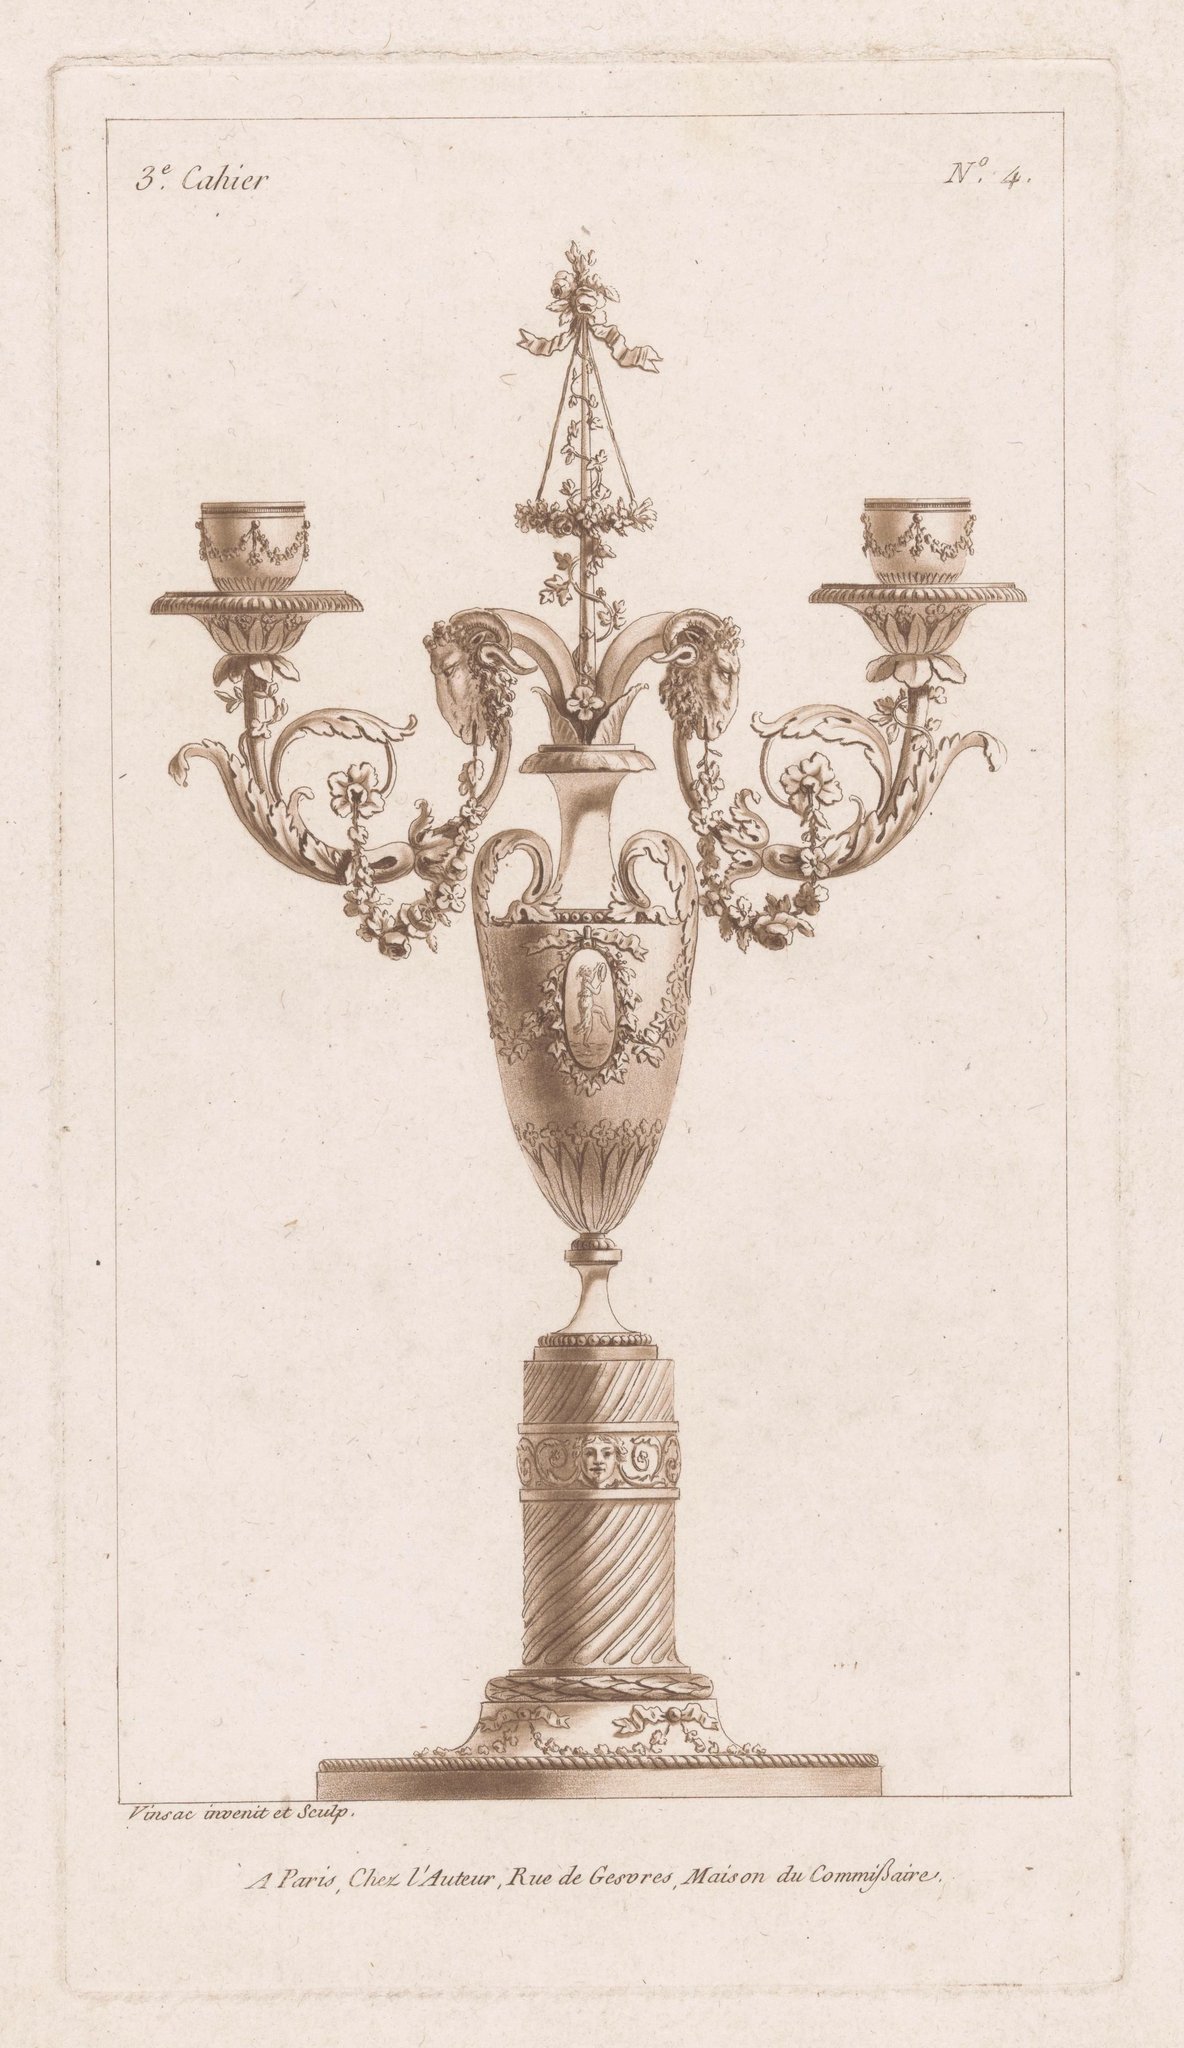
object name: print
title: 3e Cahier / Cahier des Girandoles de Bureau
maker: claude dominique vinsac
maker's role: print maker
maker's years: 1749-1800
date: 1759-1800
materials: paper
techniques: aquatint, etching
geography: paris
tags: chandelier, candelabrum, caduceus (staff with two snakes, attribute of mercury)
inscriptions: collector's mark: Lugt 2228, collector's mark: Lugt 2760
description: Een tweearmige girandole met ranken, vlechtwerk, maskers en een caduceus.